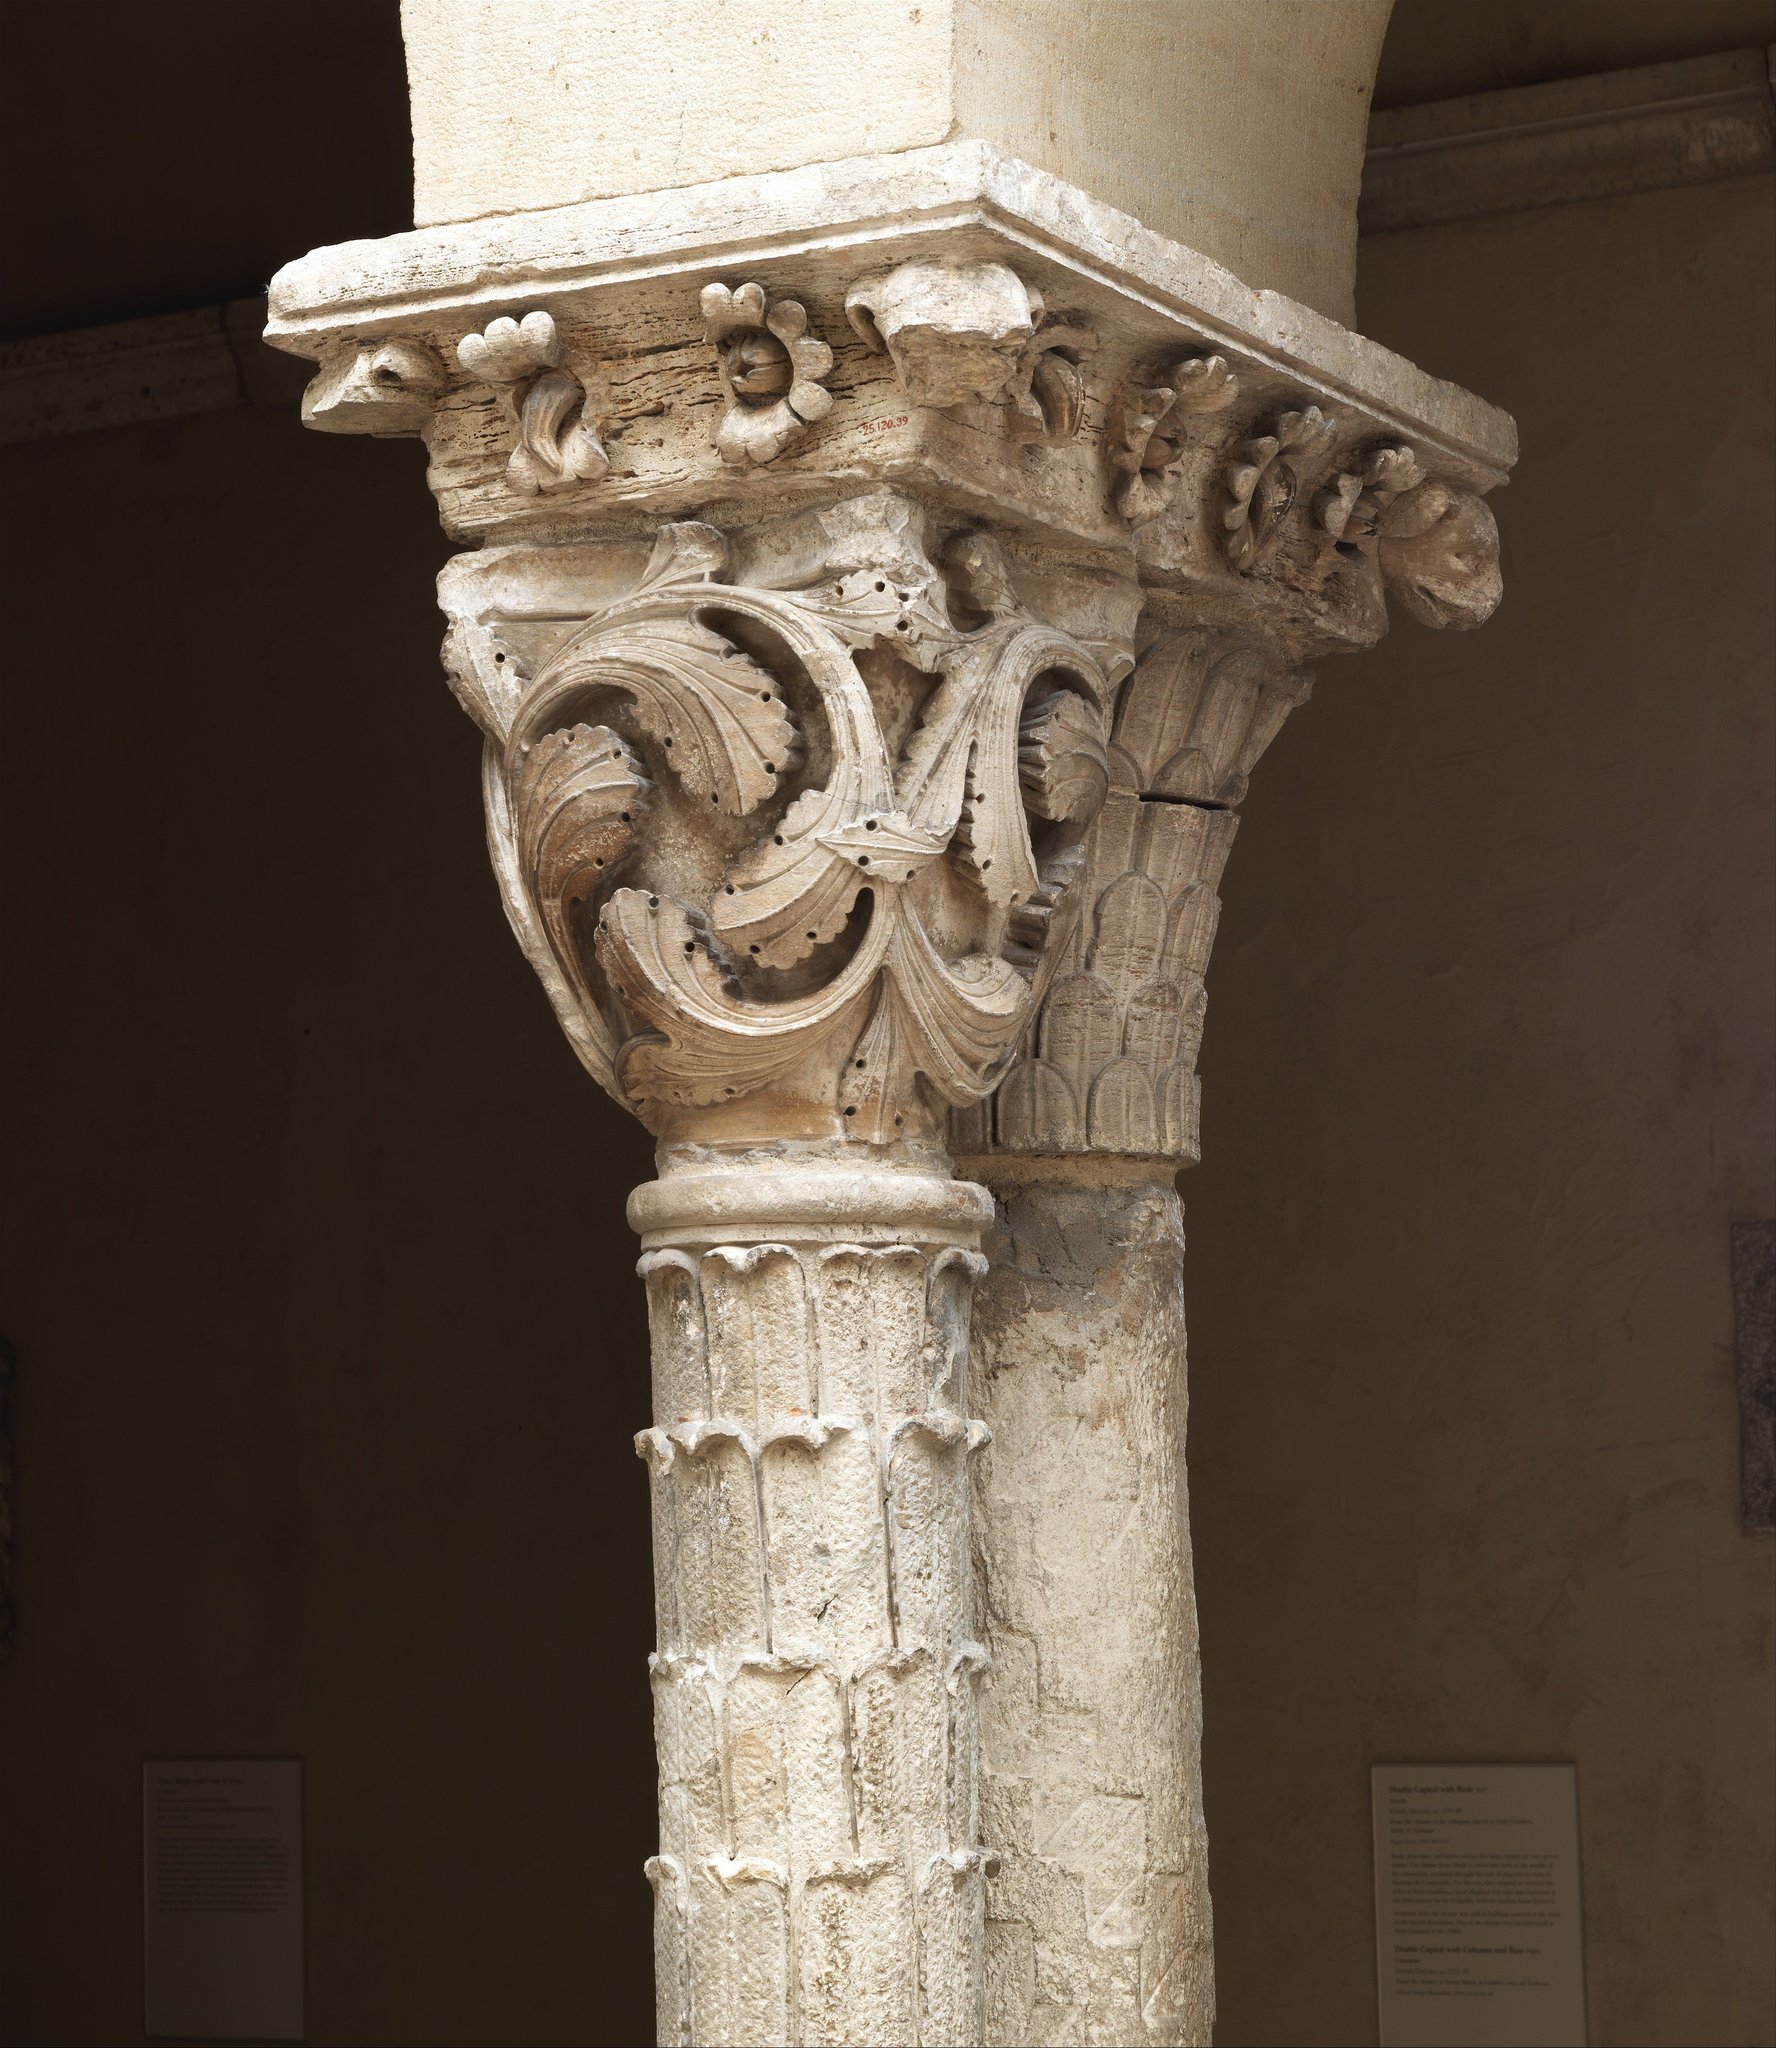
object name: capital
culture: french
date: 1167-1200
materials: stone